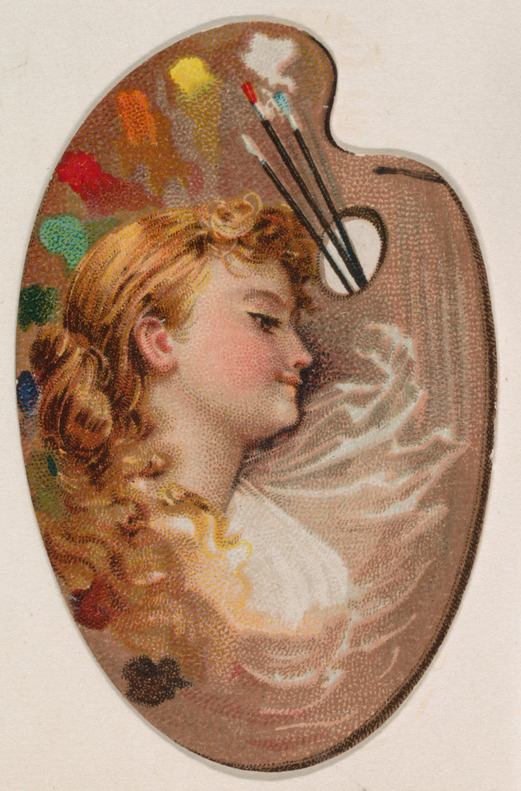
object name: print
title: Artist's paint pallette, from the Novelties series (N228, Type 3) issued by Kinney Bros.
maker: kinney brothers tobacco company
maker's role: publisher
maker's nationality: american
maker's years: 1869-2011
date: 1889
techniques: color lithograph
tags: profiles,women